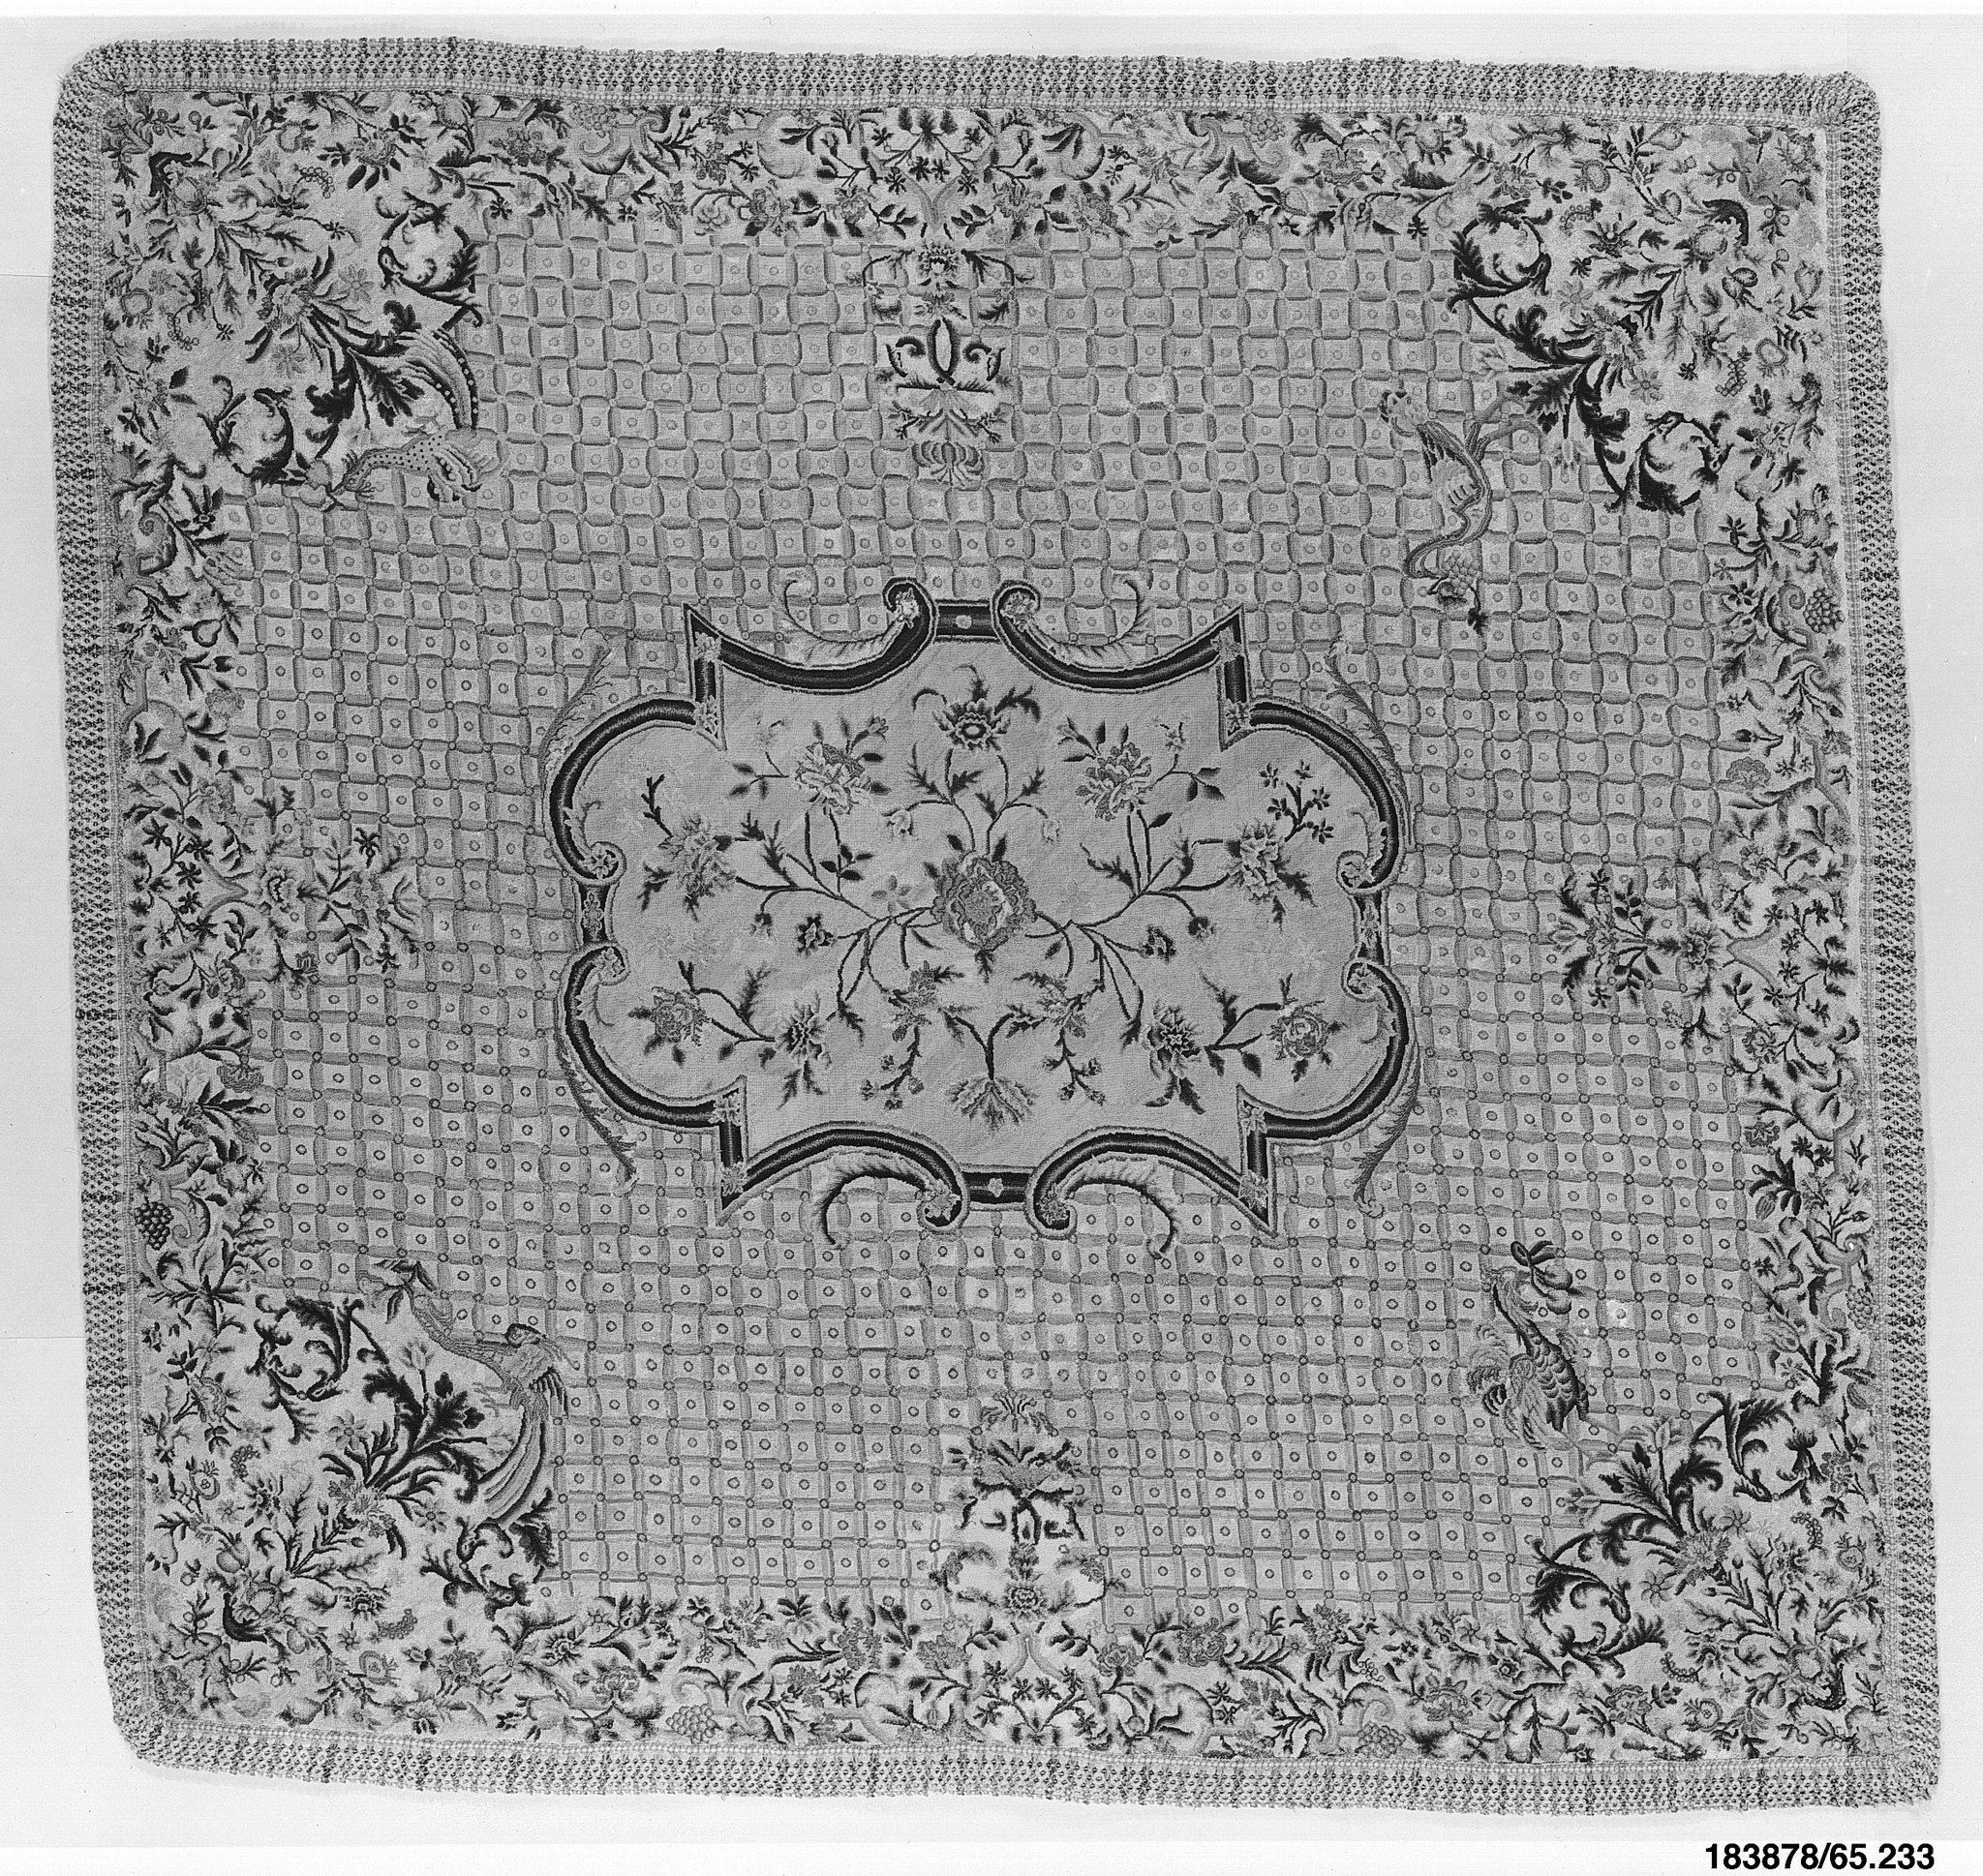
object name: carpet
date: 1701-1800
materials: silk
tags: flowers